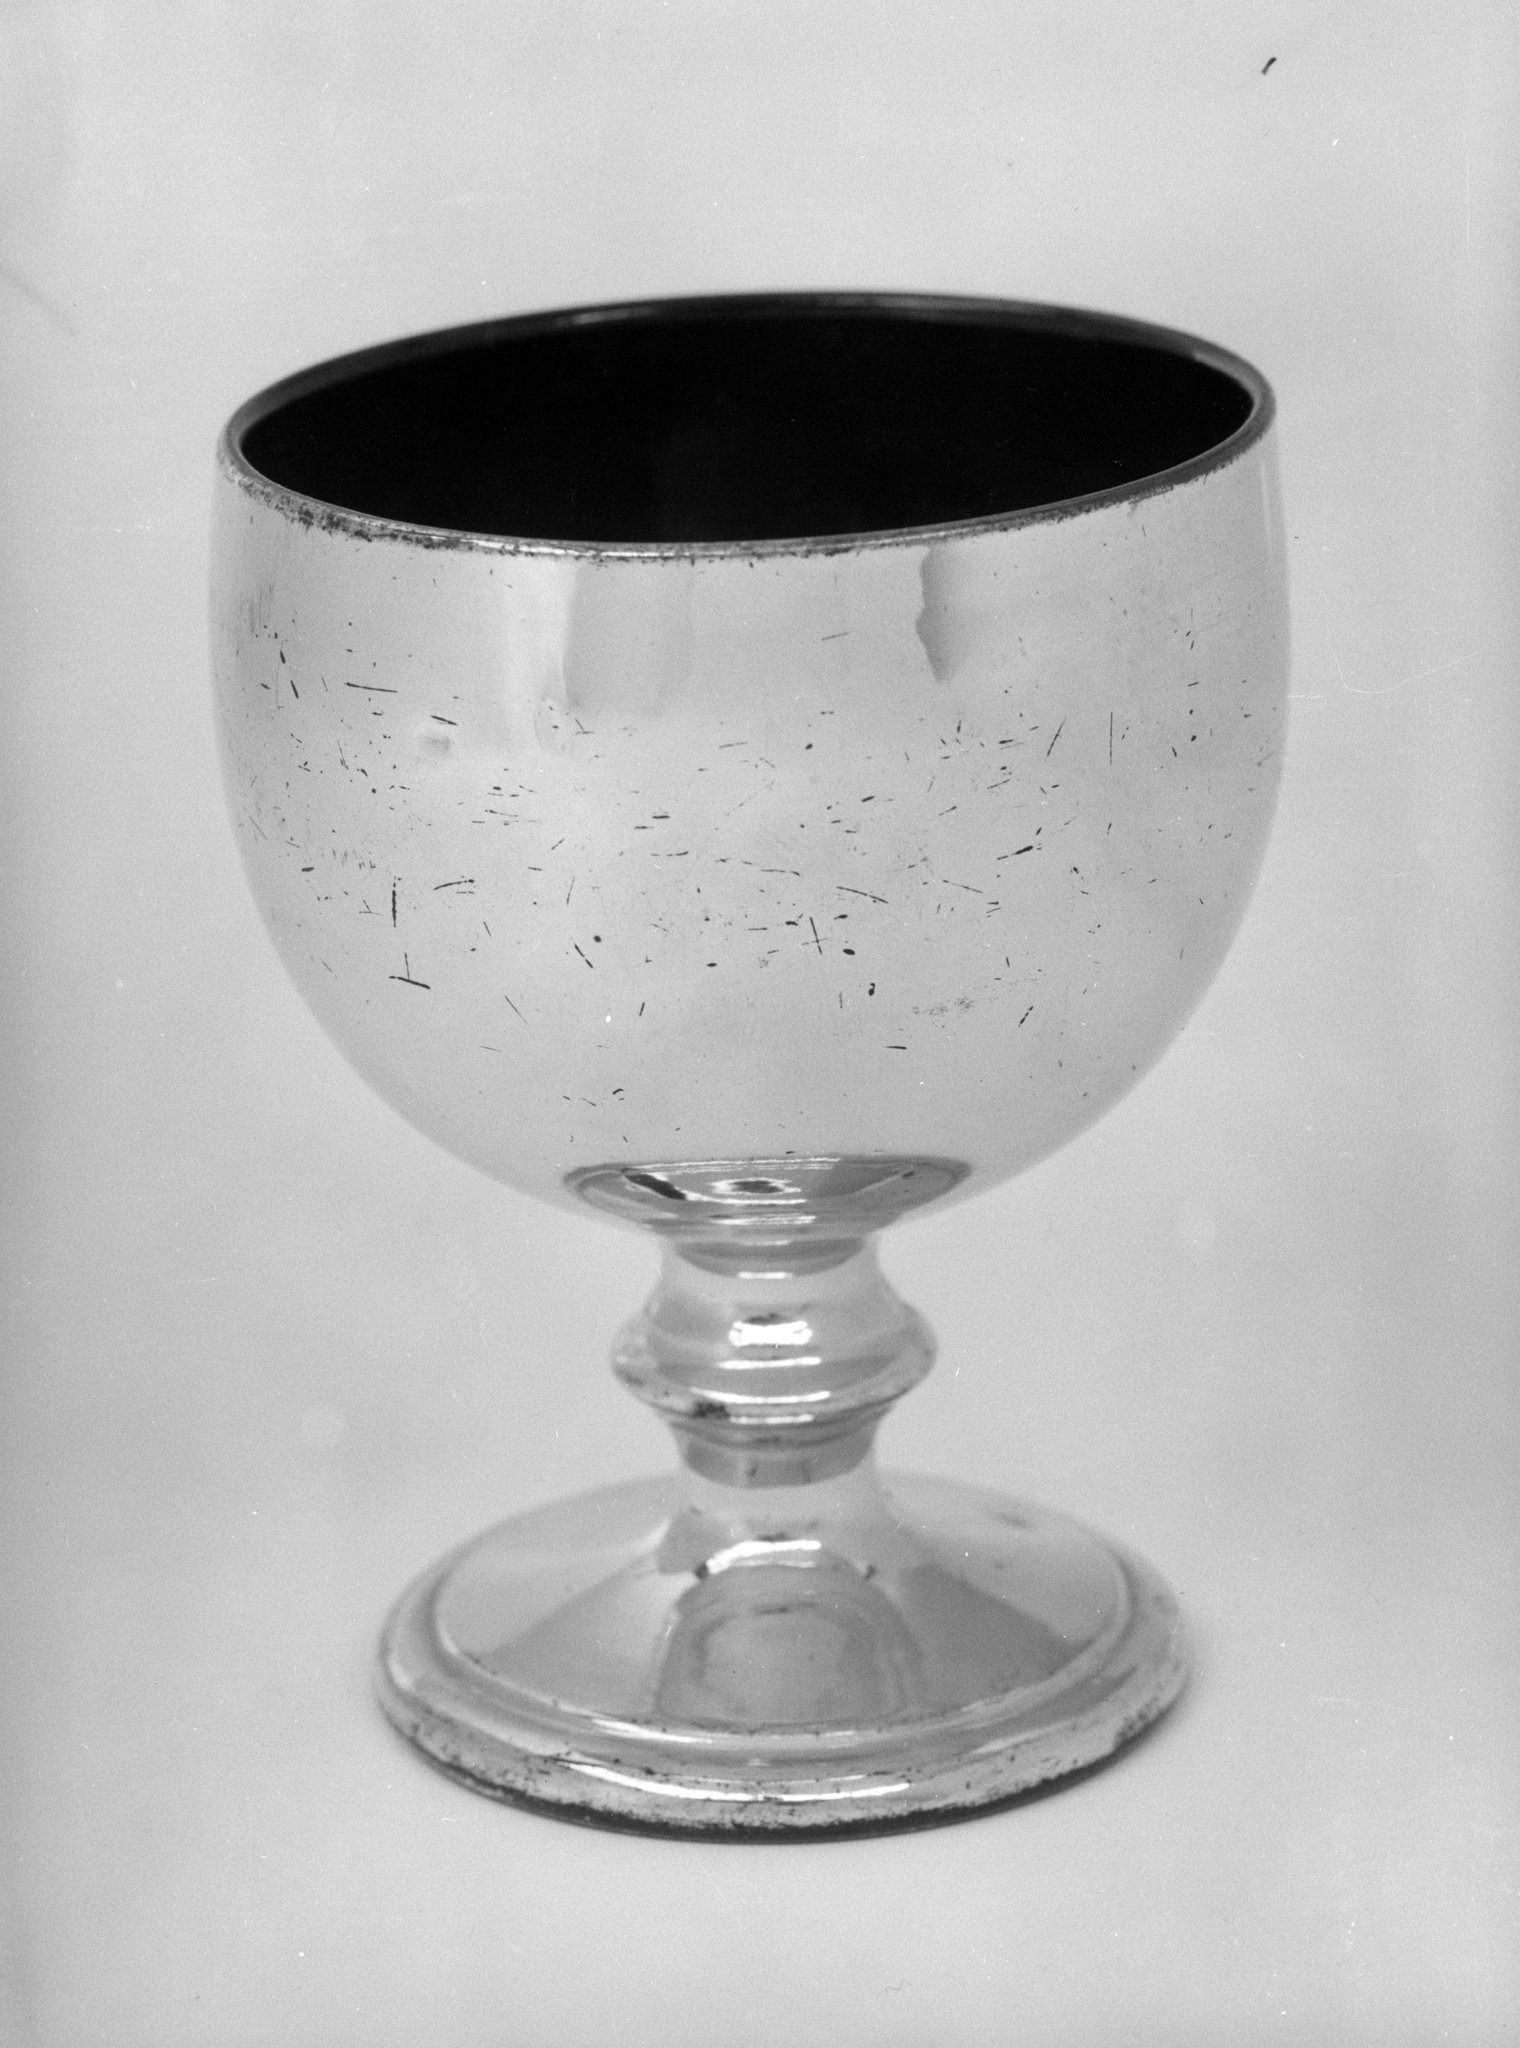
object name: goblet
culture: british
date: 1800-1830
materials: earthenware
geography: england